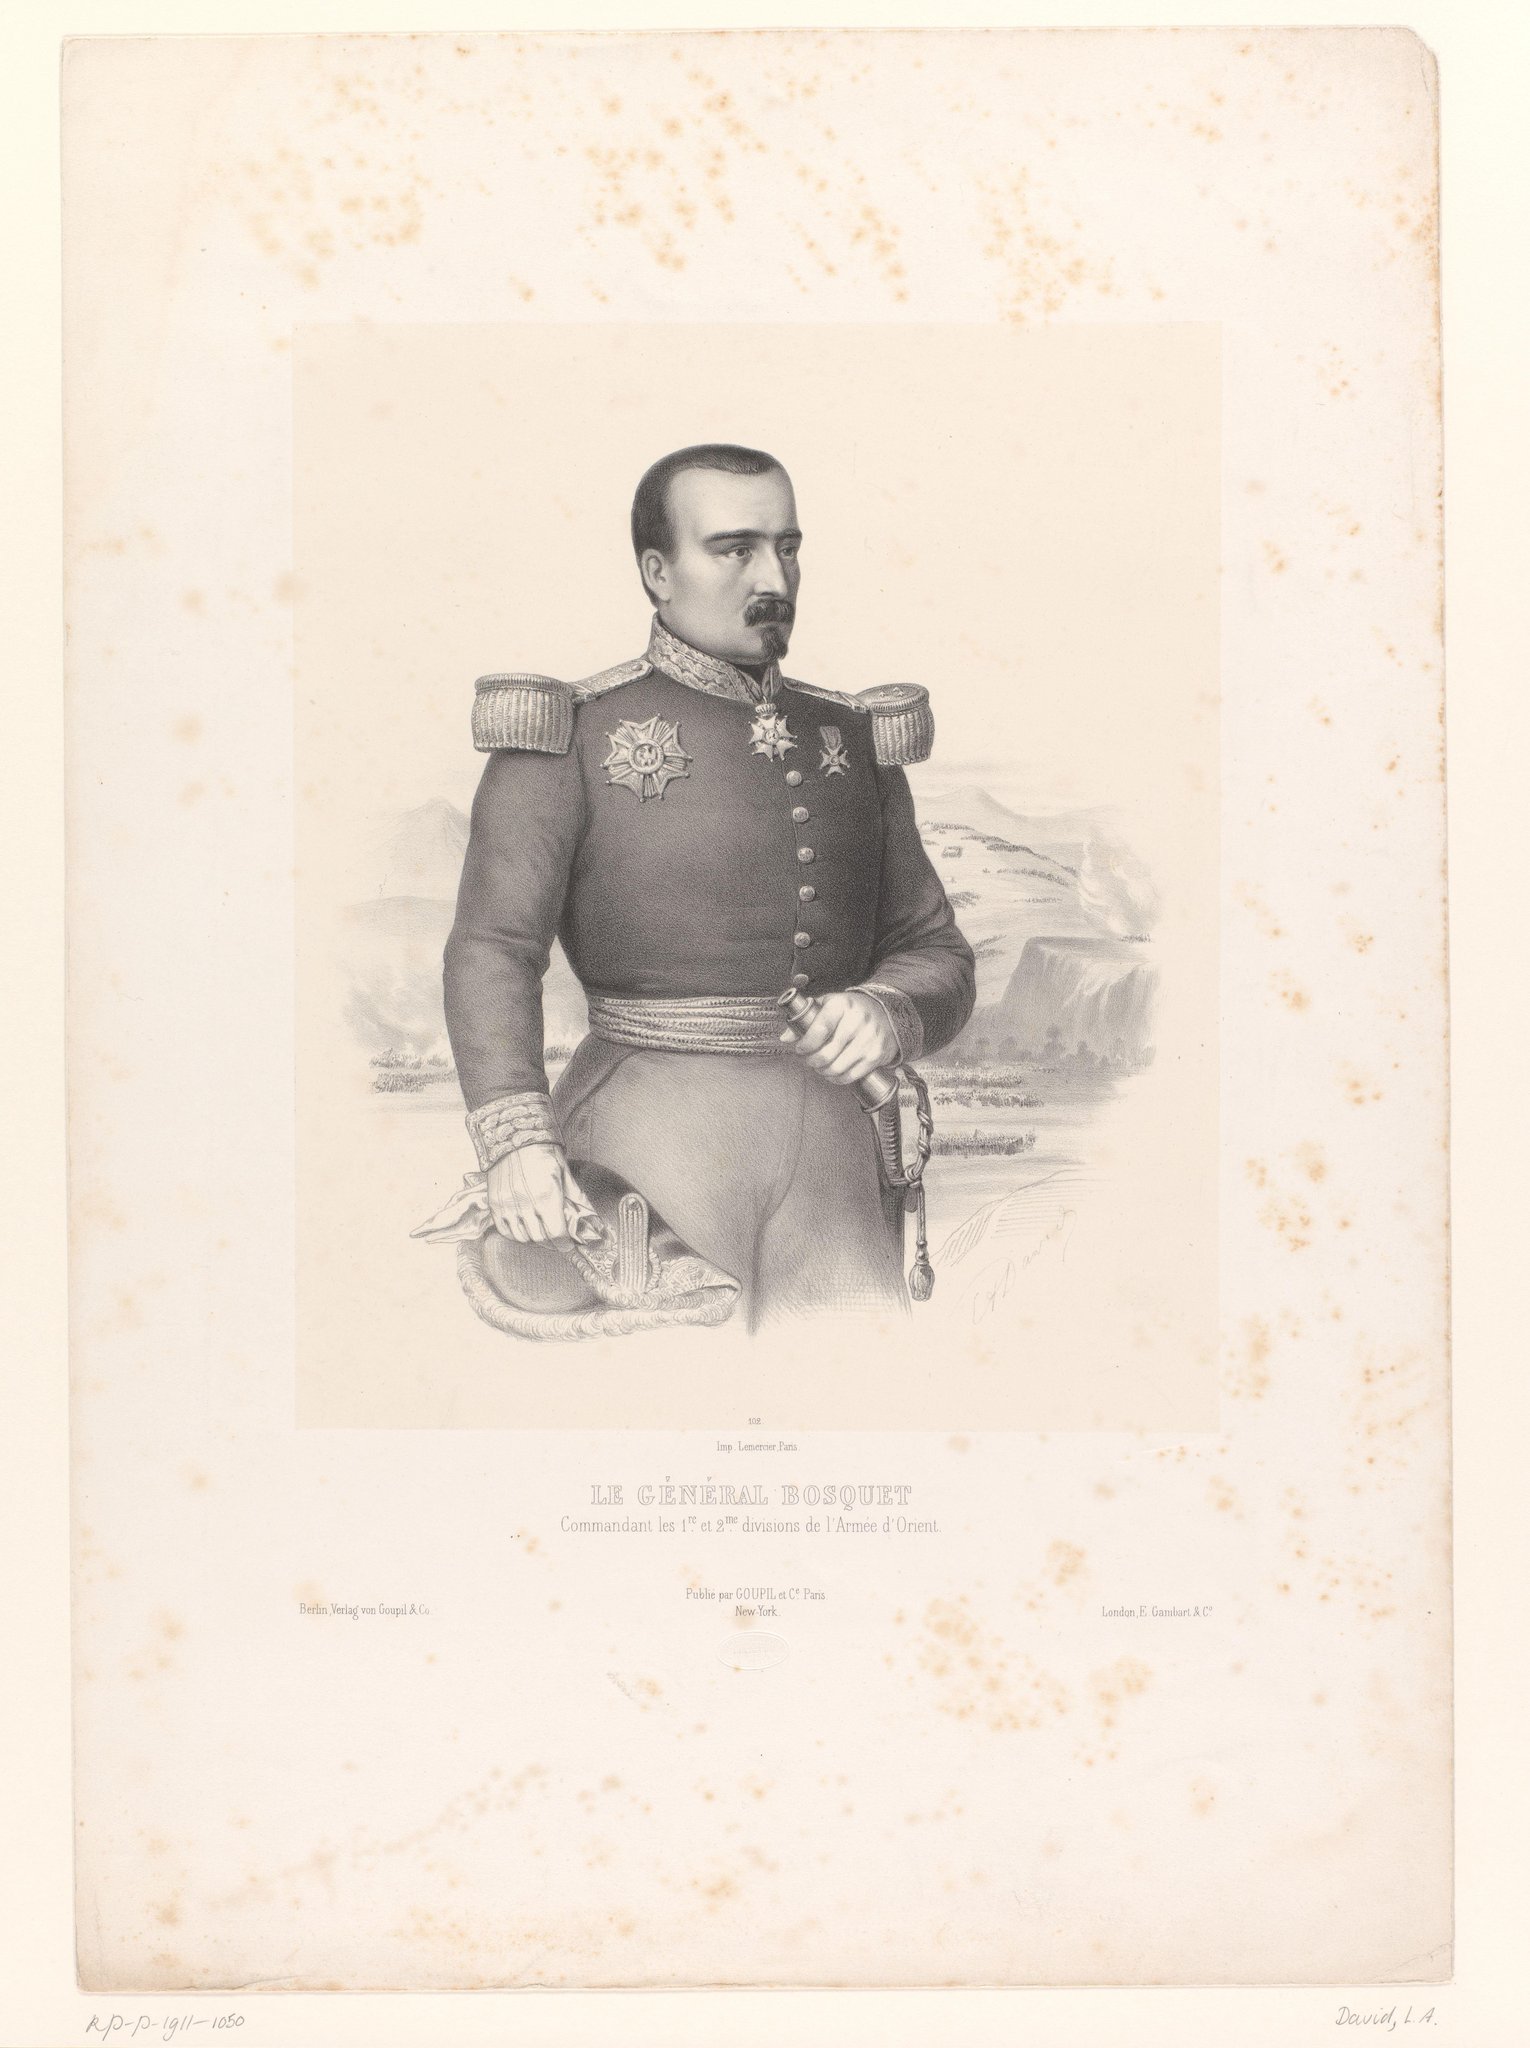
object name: print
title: Portret van generaal Pierre François Bosquet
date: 1849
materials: paper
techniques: lithograph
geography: paris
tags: historical persons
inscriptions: check stamp: Lugt 1090, collector's mark: Lugt 2228a